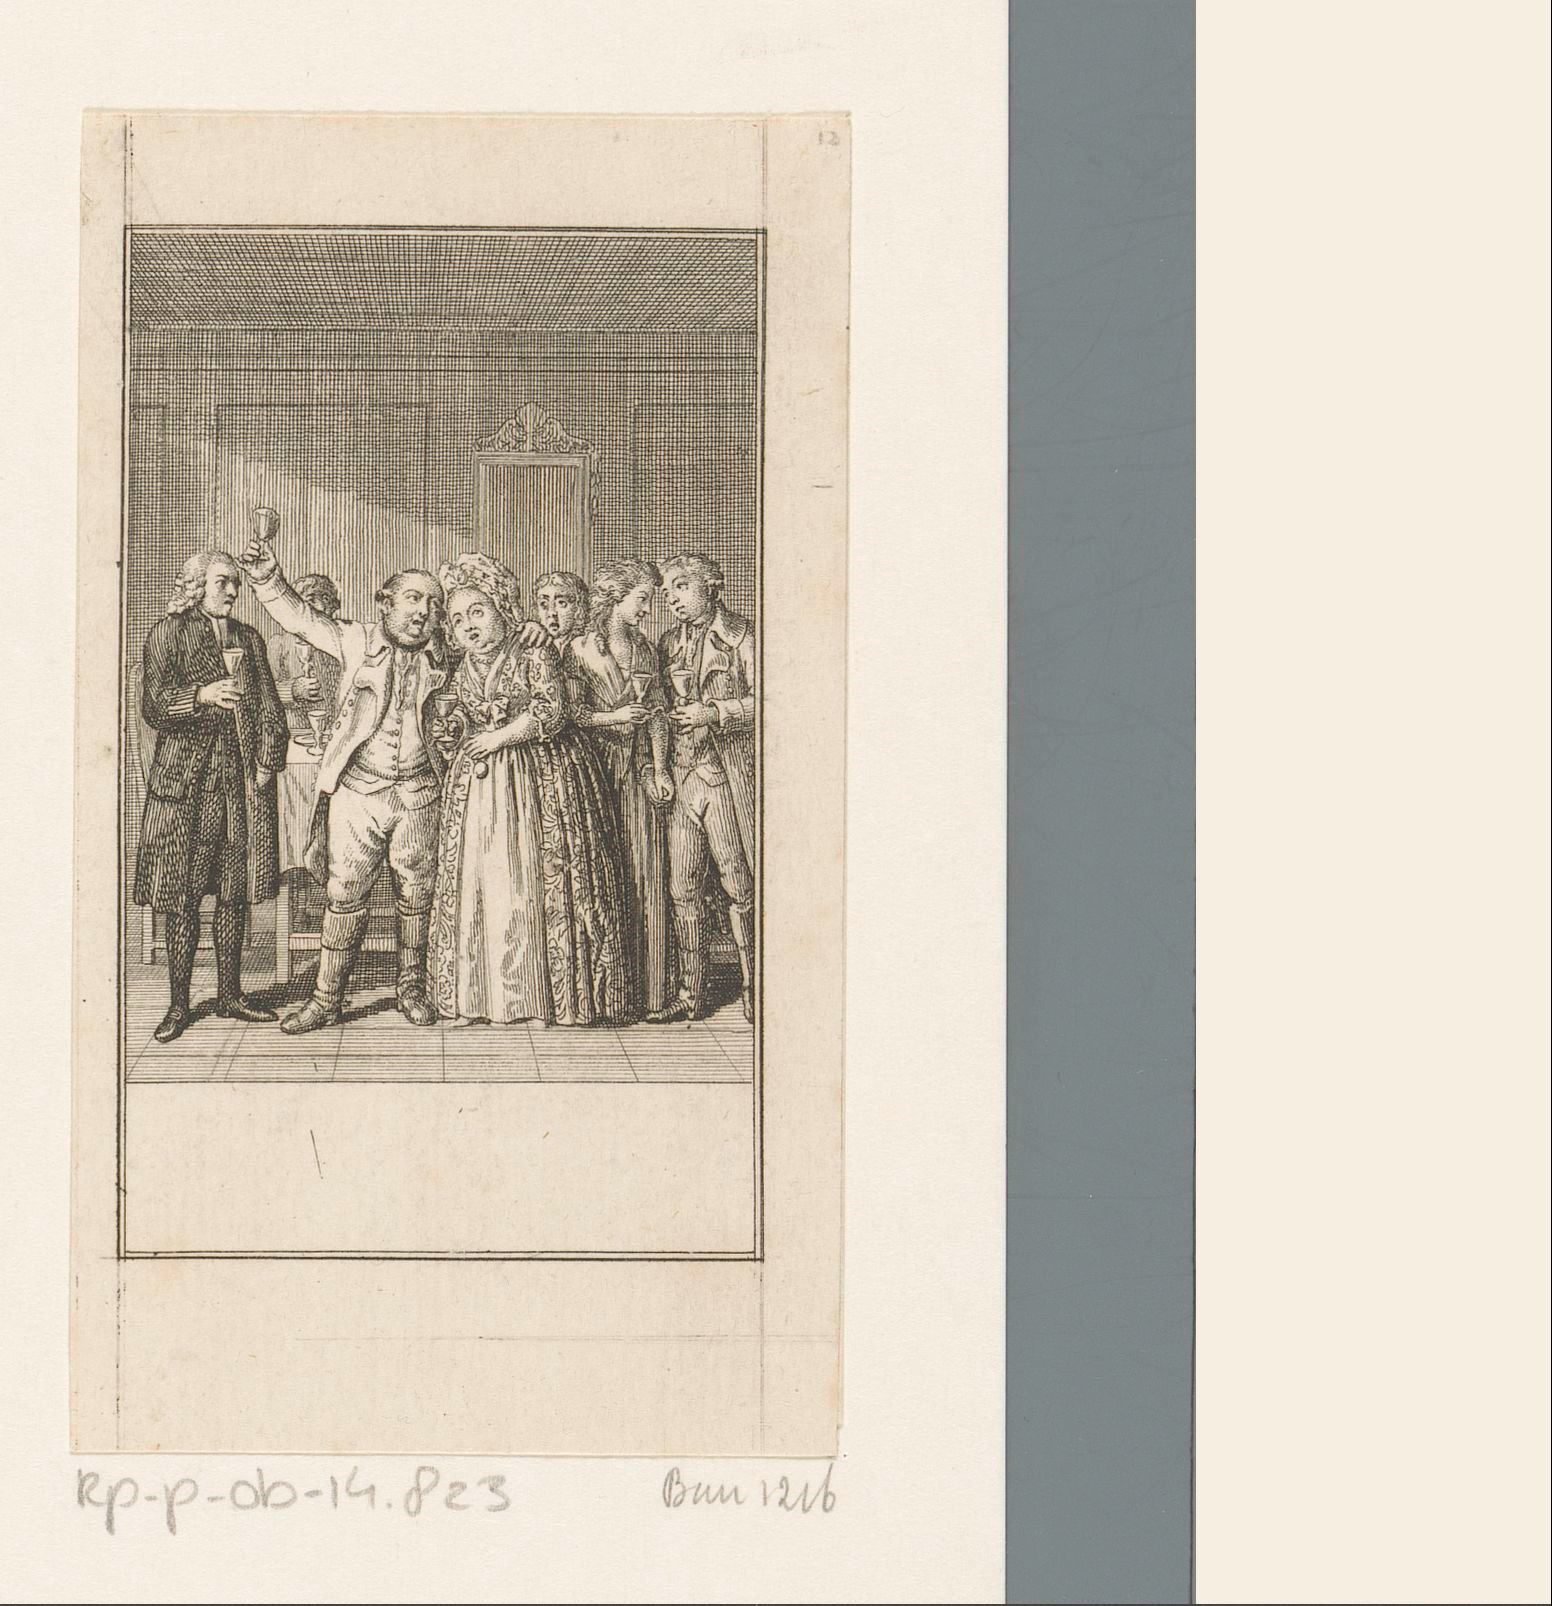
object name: print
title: Zingend gezelschap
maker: daniel nikolaus chodowiecki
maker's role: draughtsman, print maker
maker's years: 1726-1801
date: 1786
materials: paper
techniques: etching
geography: berlin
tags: literature, vocal music, singing, glass of wine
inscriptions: collector's mark: Lugt 2228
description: Vervaardigd voor August Wilhelm Ifflands 'Die Jäger'. Latere staat gebruikt voor: Berliner genealogischen Calender auf das Jahr 1787. Berlijn: s.n., 1786.